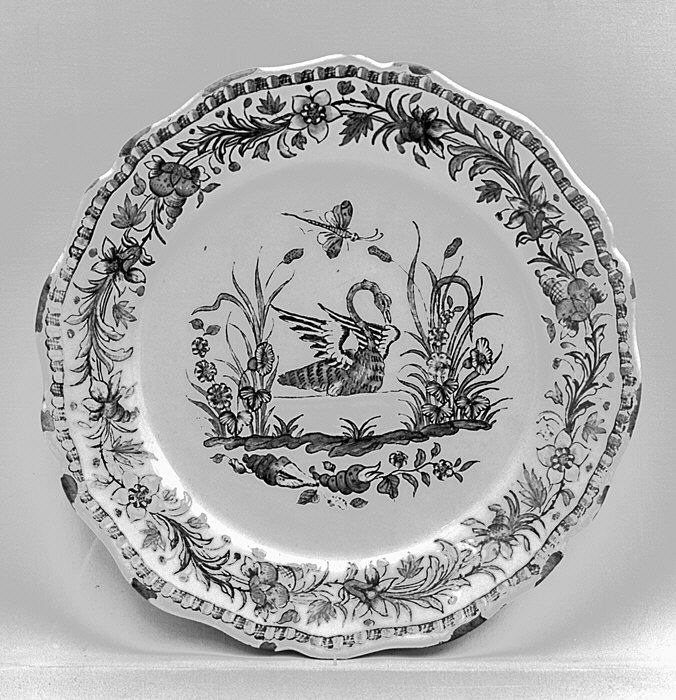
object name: plate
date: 1701-1800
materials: faience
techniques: glazing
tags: birds,insects,flowers